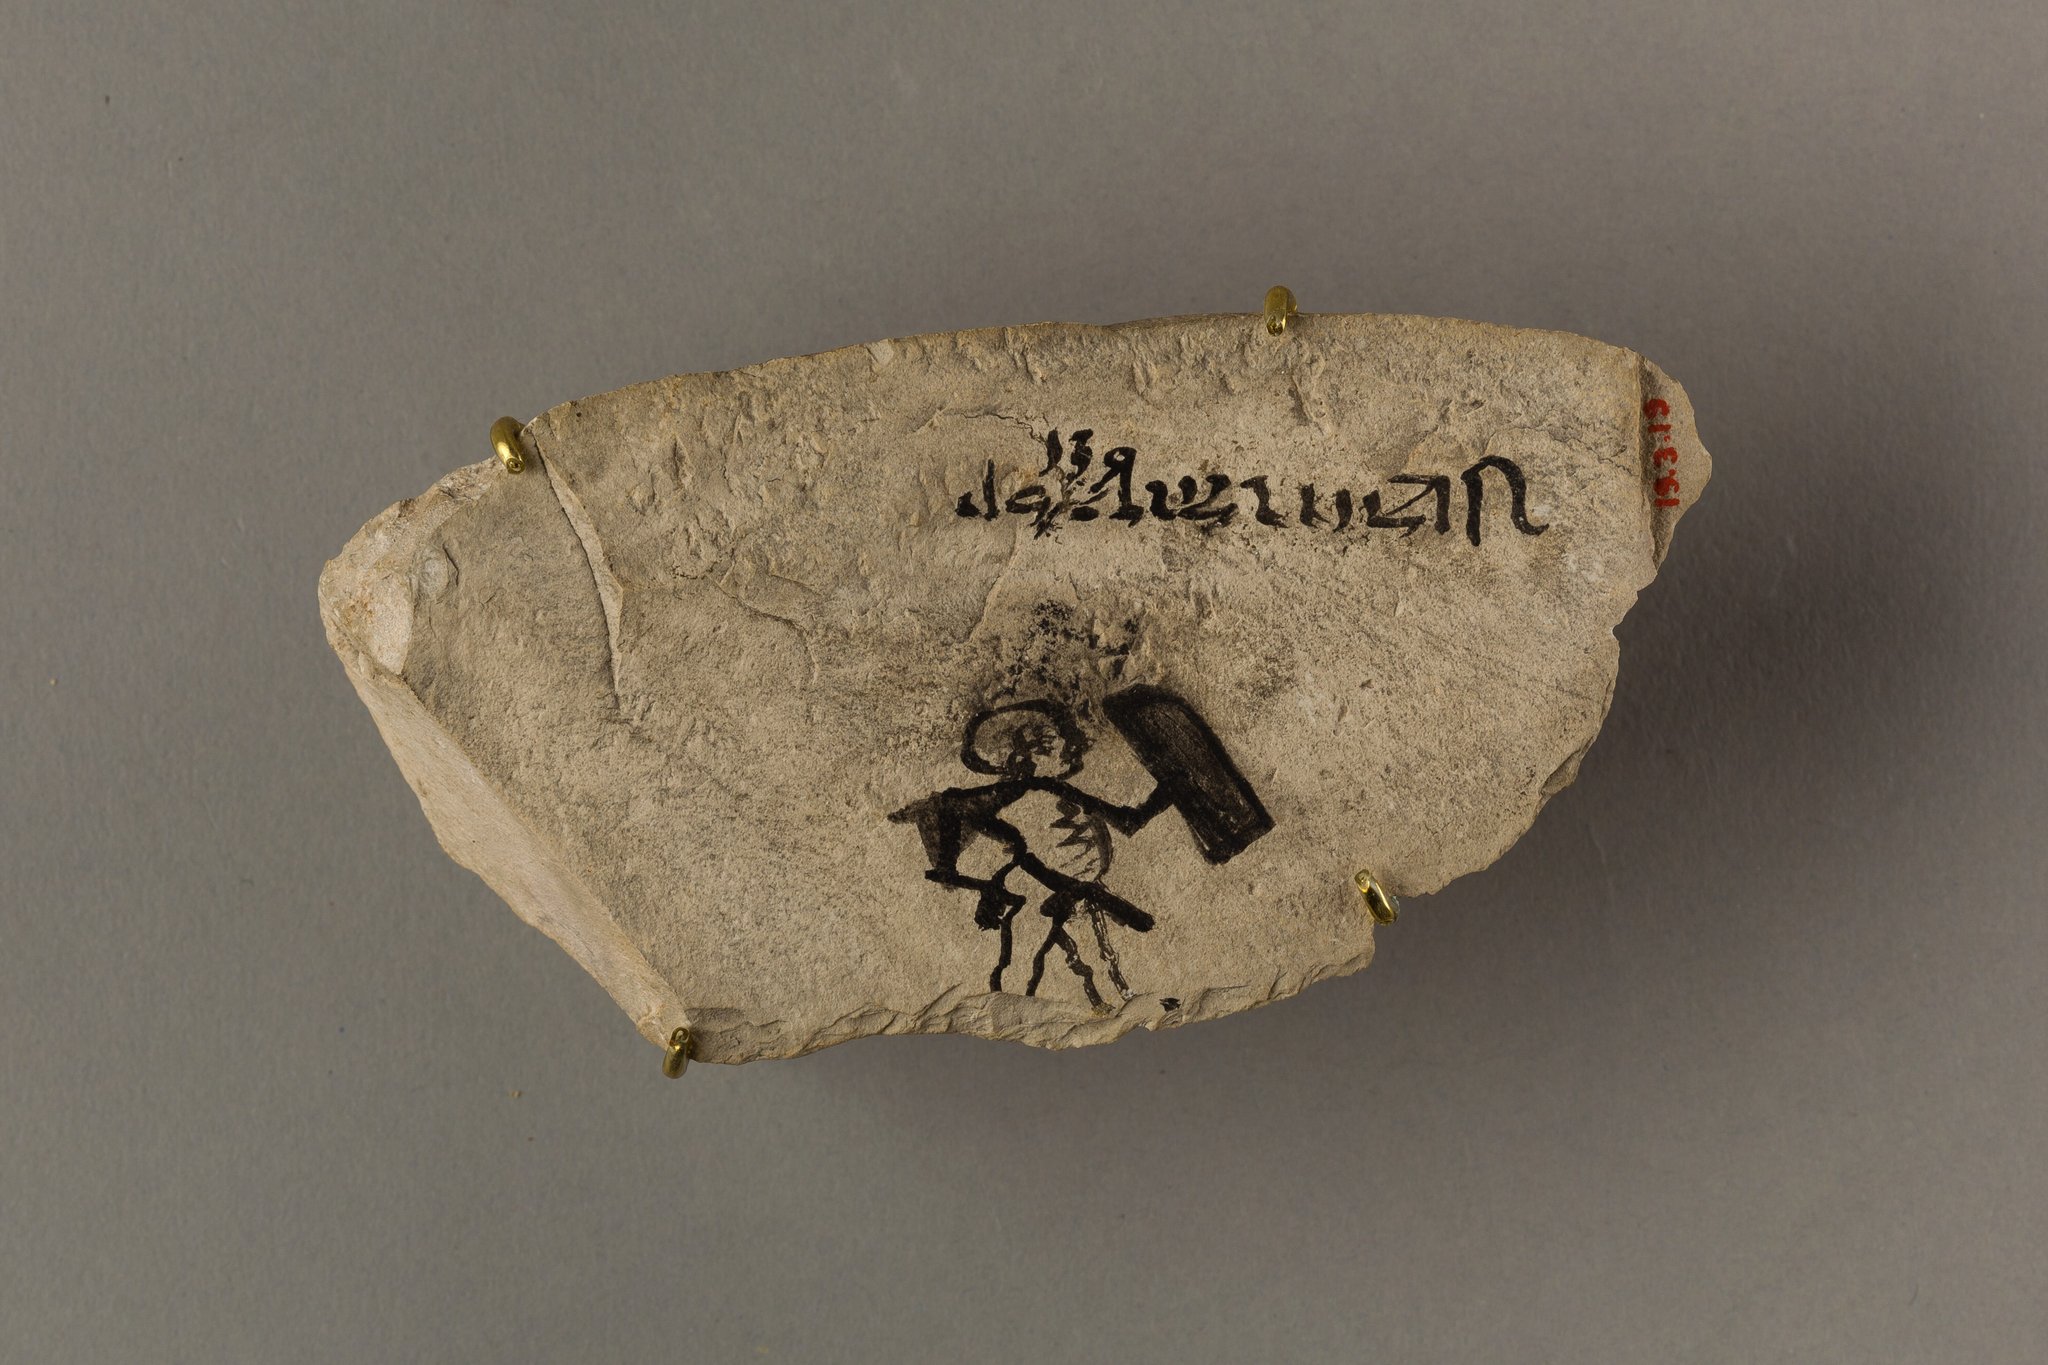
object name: ostracon, hieratic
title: Ostracon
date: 1295-1070 BCE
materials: ink, limestone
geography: egypt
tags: human figures,hieratic